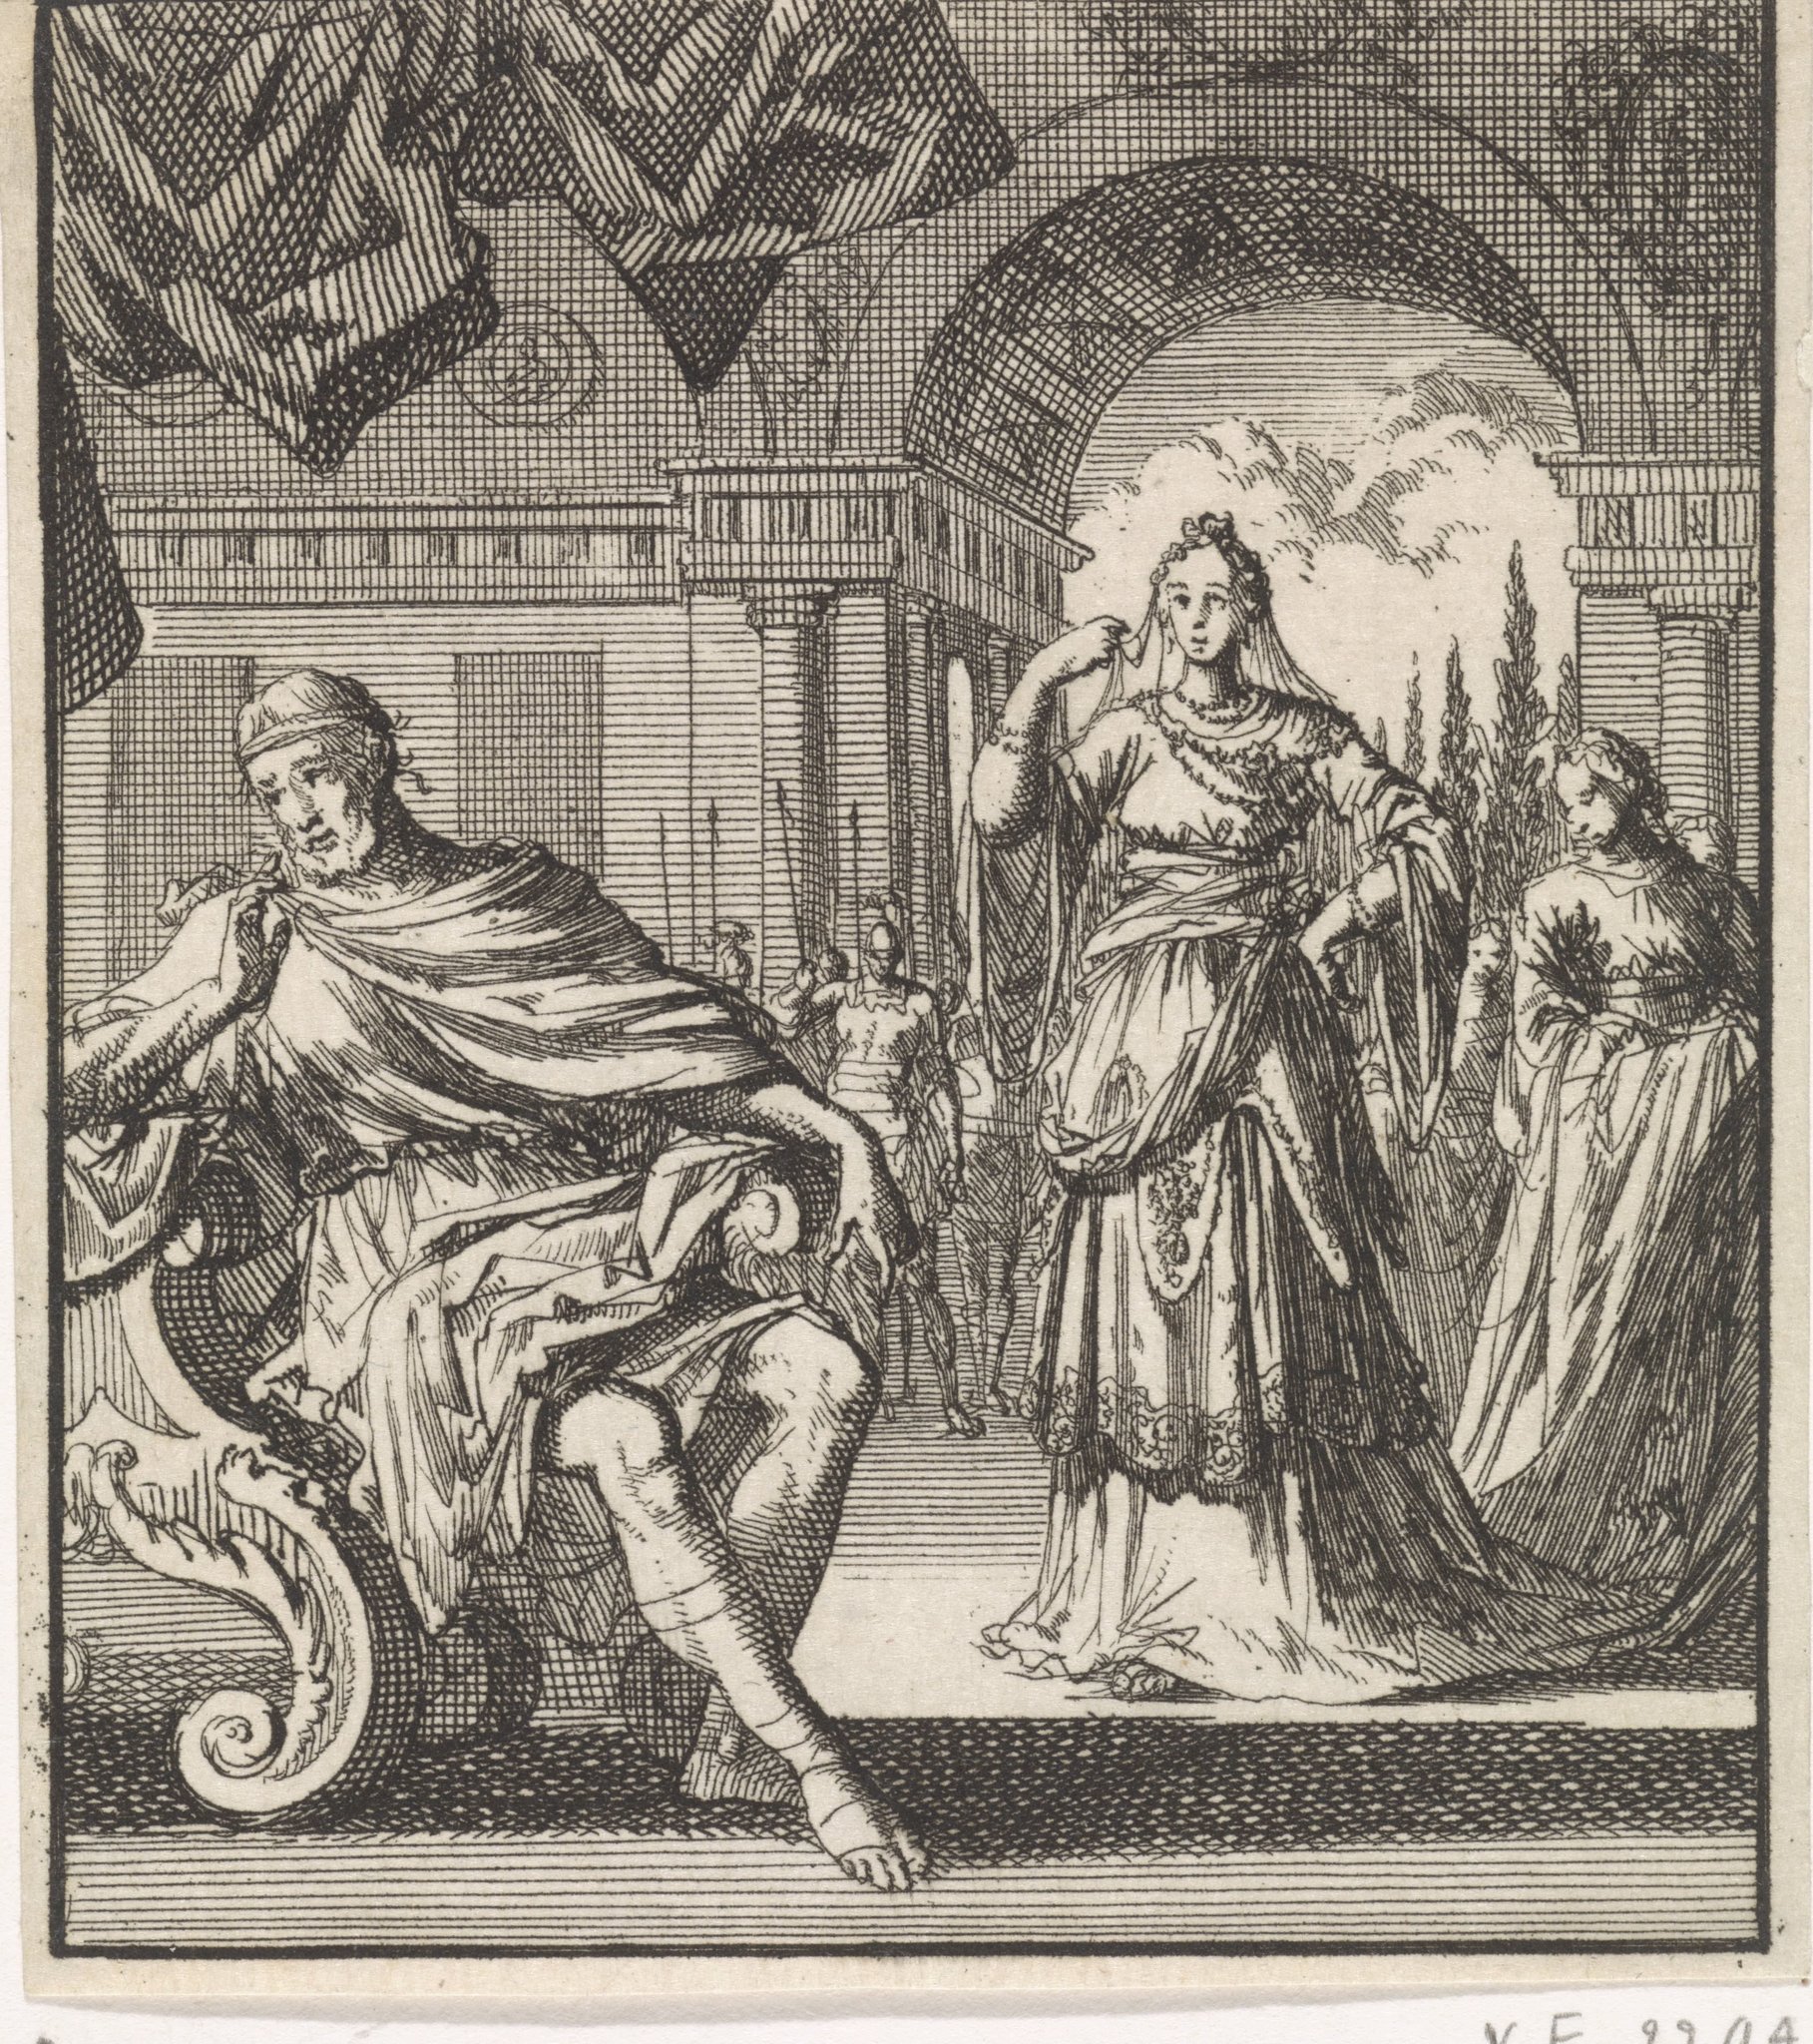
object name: print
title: Keizer weigert te kijken naar zijn dochter Julia, die sierlijk gekleed is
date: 1699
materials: paper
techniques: etching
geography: amsterdam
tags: father and daughter(s) (family group), emperor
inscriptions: collector's mark: Lugt 2228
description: Boekillustratie voor Jocelijn, Elisabeth. Uyterste wille van een moeder aan haar toekomende kind. Amsterdam: J. van Nieuweveen, 1699.